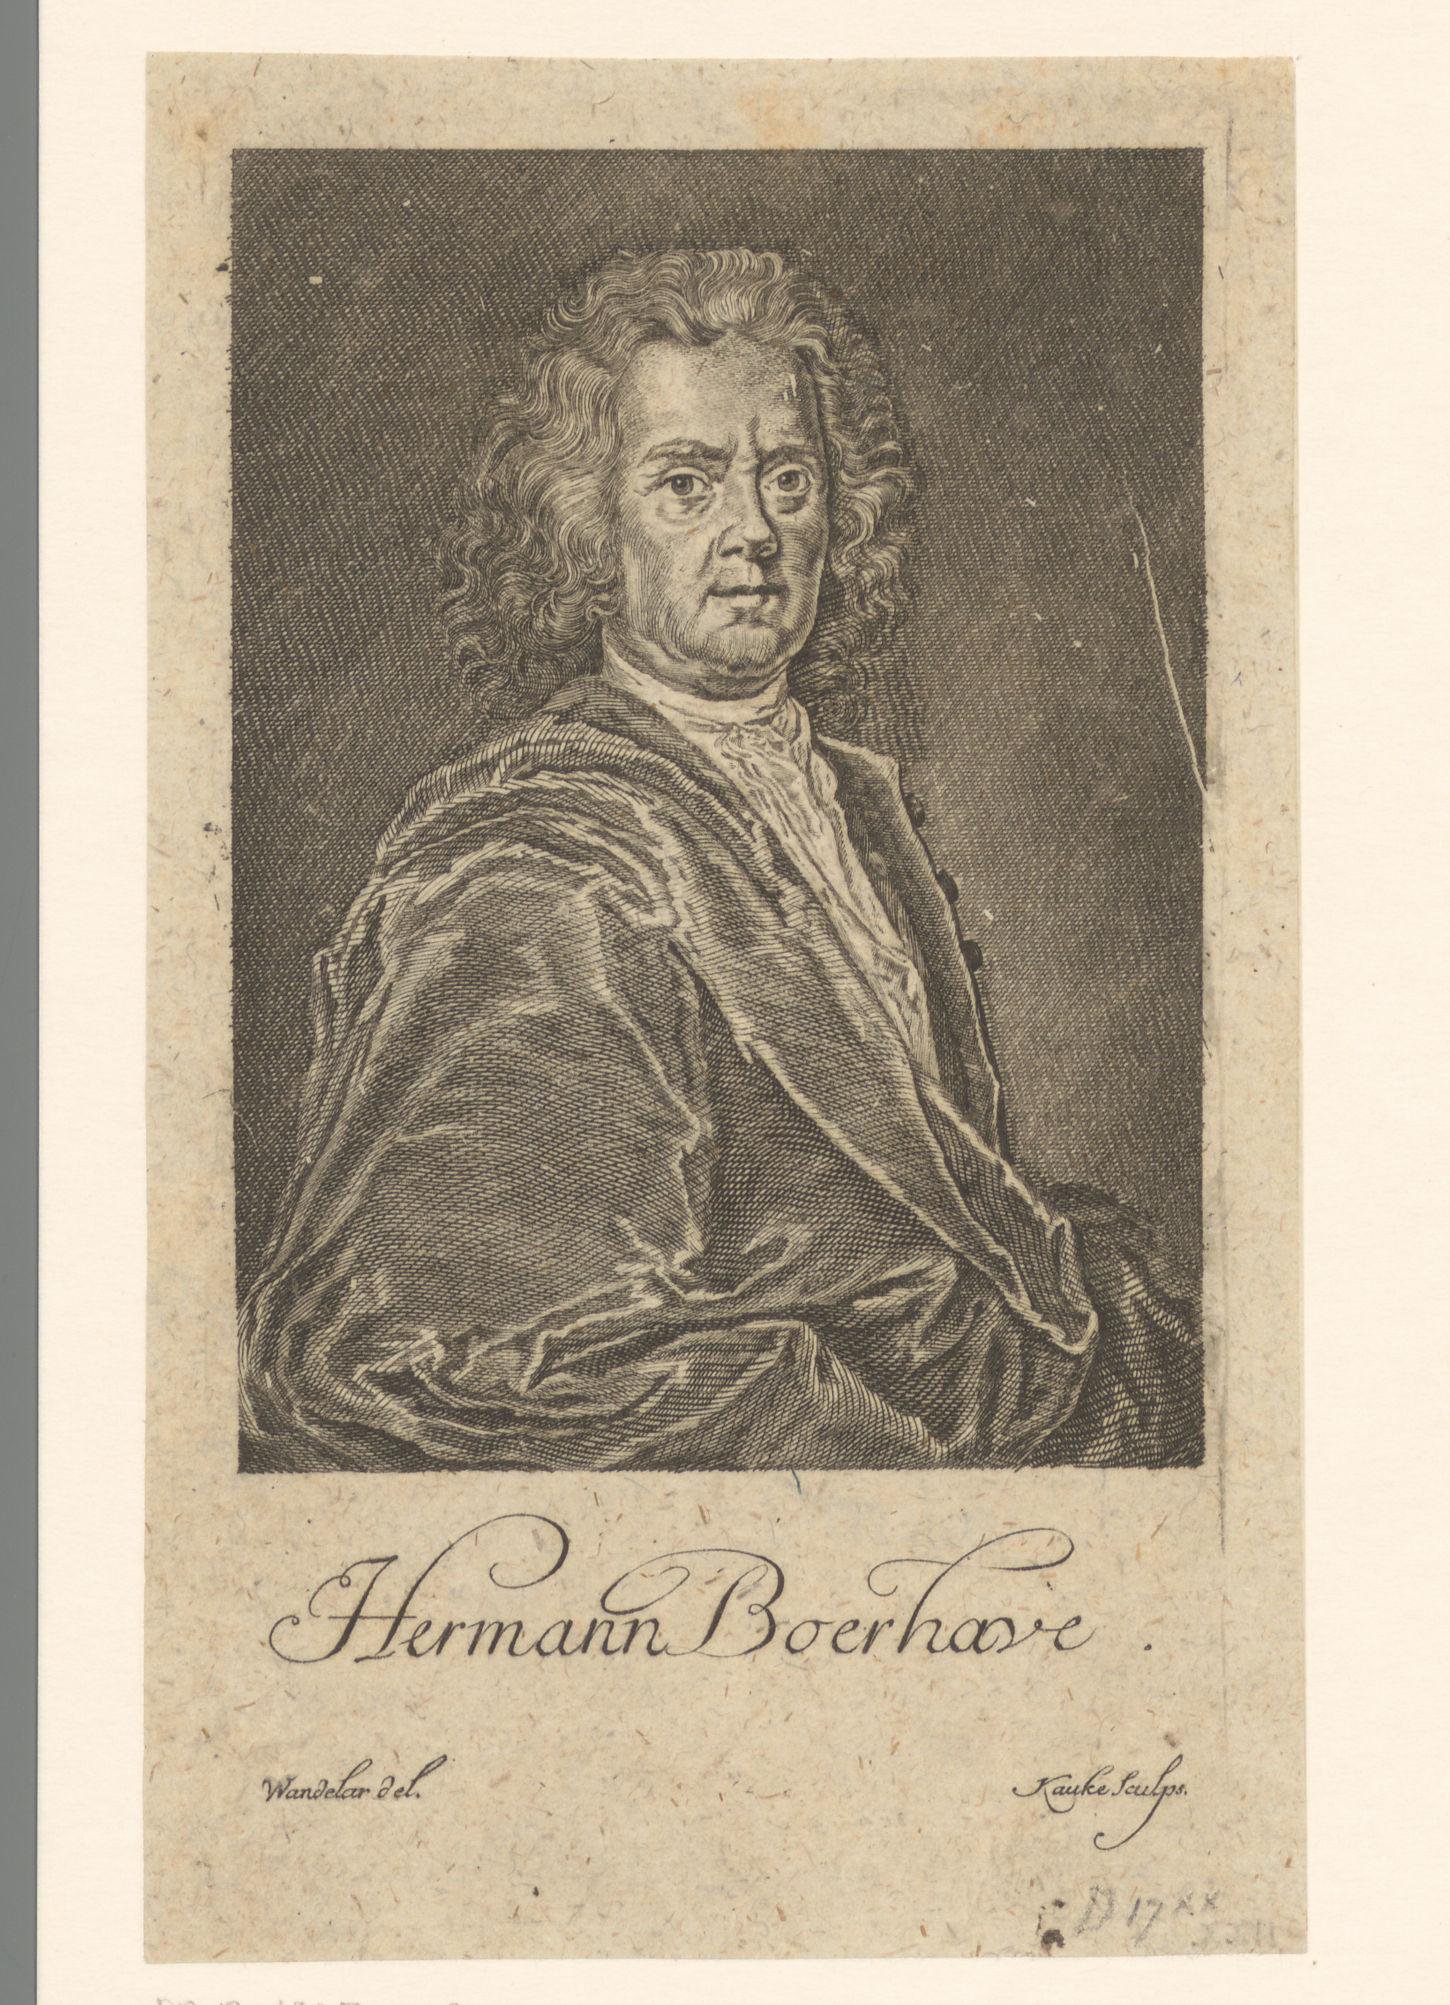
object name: print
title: Portret van Hermannus Boerhaave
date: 1725-1777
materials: paper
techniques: engraving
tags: leiden, hermanus boerhaave, historical persons, physician, doctor (+ portrait of scholar, scientist), biology (+ portrait of scholar, scientist)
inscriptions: collector's mark: Lugt 2228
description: Deze prent is mogelijk gemaakt naar de tekening van Jan Wandelaar uit ca. 1725-1749, welke zich in de collectie van het Amsterdam Museum bevindt onder inv.nr. 38470.